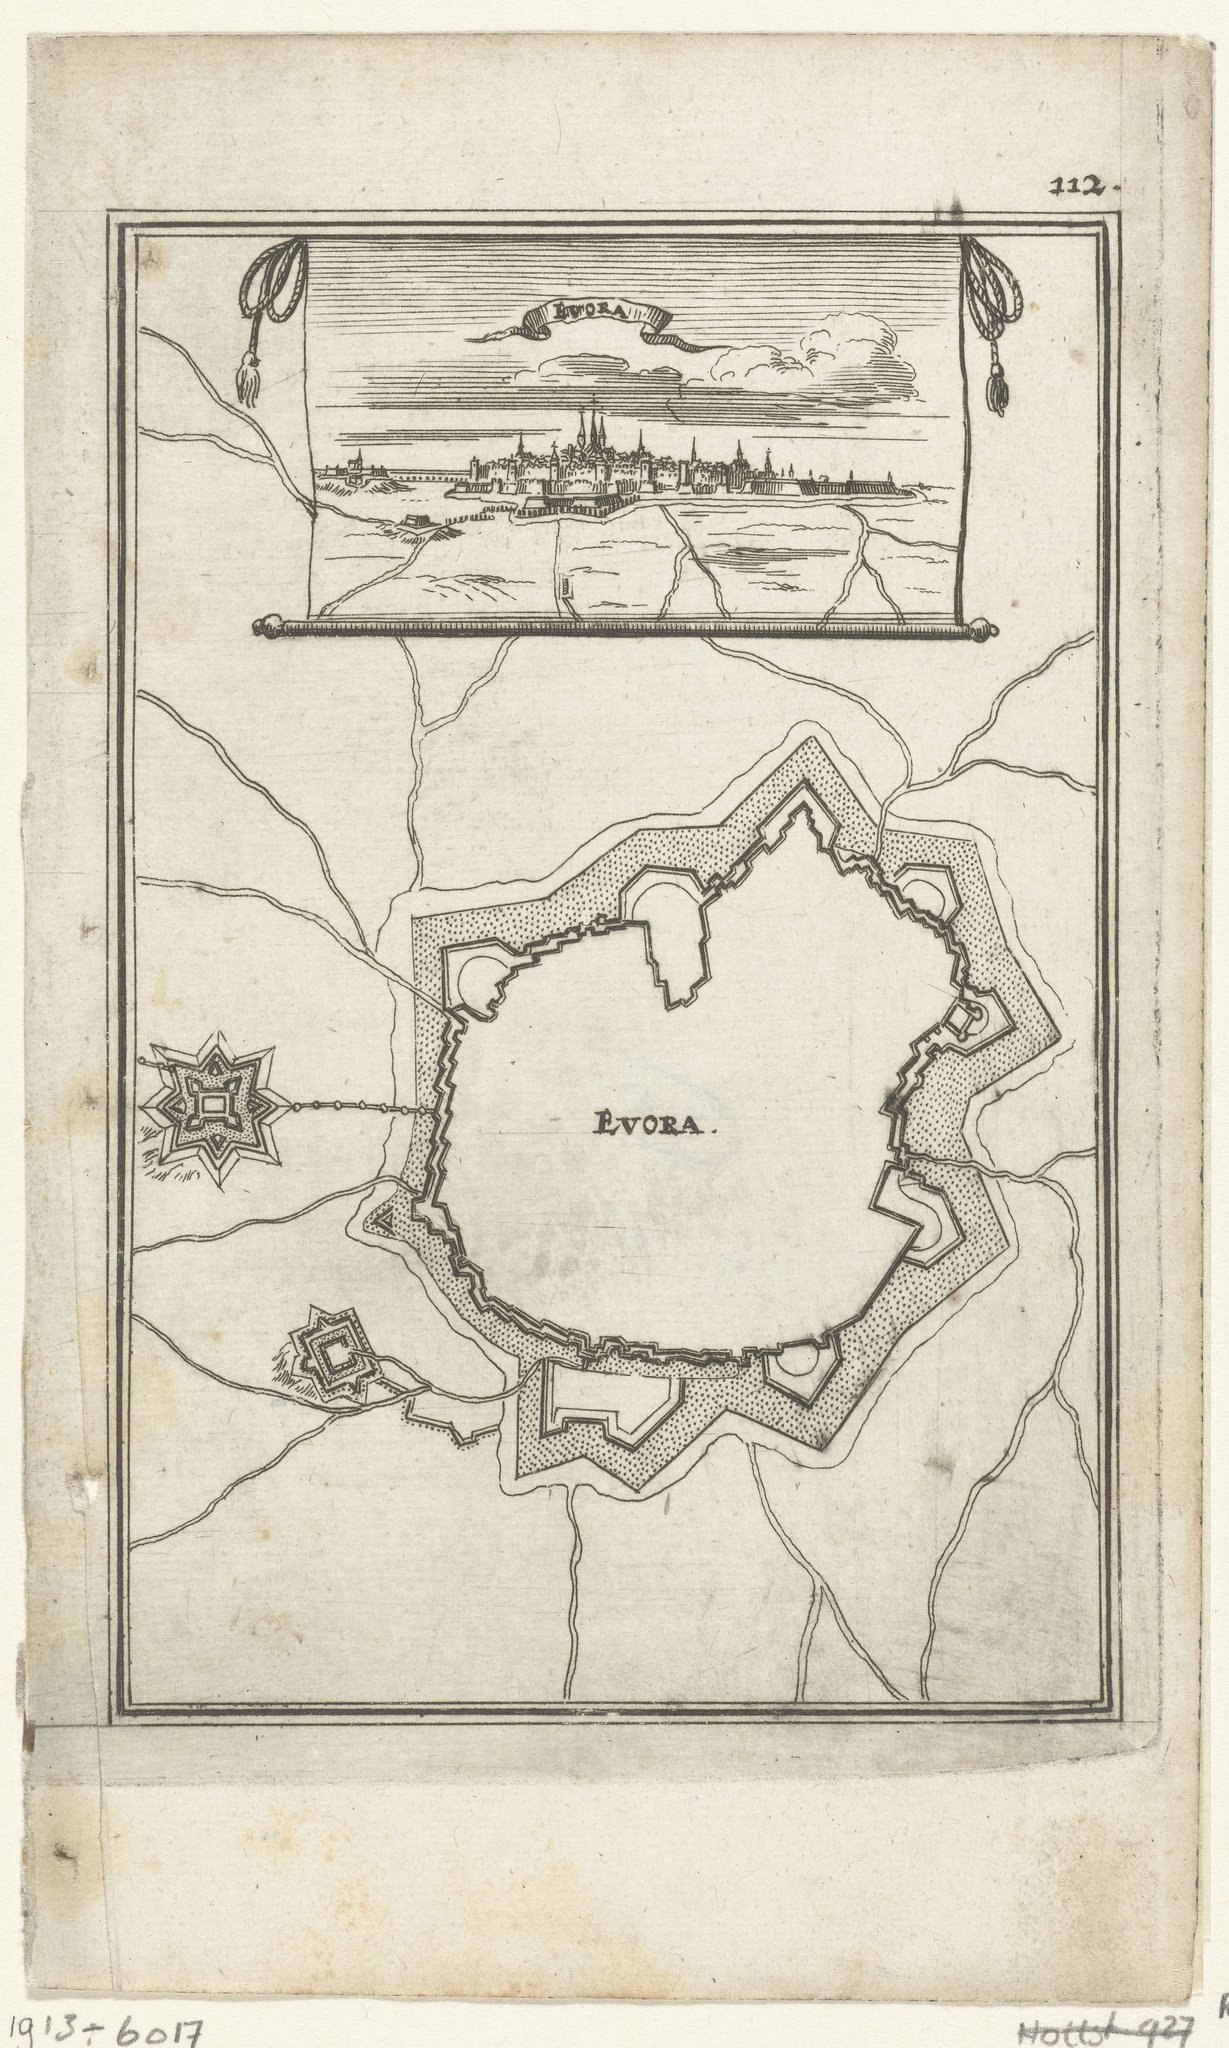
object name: book illustration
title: Illustratie voor 'Den Arbeid van Mars' van Allain Manesson Mallet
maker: romeyn de hooghe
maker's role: draughtsman, goldsmith, painter, print maker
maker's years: 1645-1708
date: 1672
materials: paper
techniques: engraving, etching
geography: amsterdam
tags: fortifications, military engineering, prospect of city, town panorama, silhouette of city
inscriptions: collector's mark: Lugt 2228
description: Grondplan van een vesting (Évora). Daarboven, als op een doek of stuk papier, een gezicht op de betreffende stad. In de hoek rechtsboven het cijfer 112 (= het nummer van de pagina in het boek waartegenover de illustratie geplaatst is).